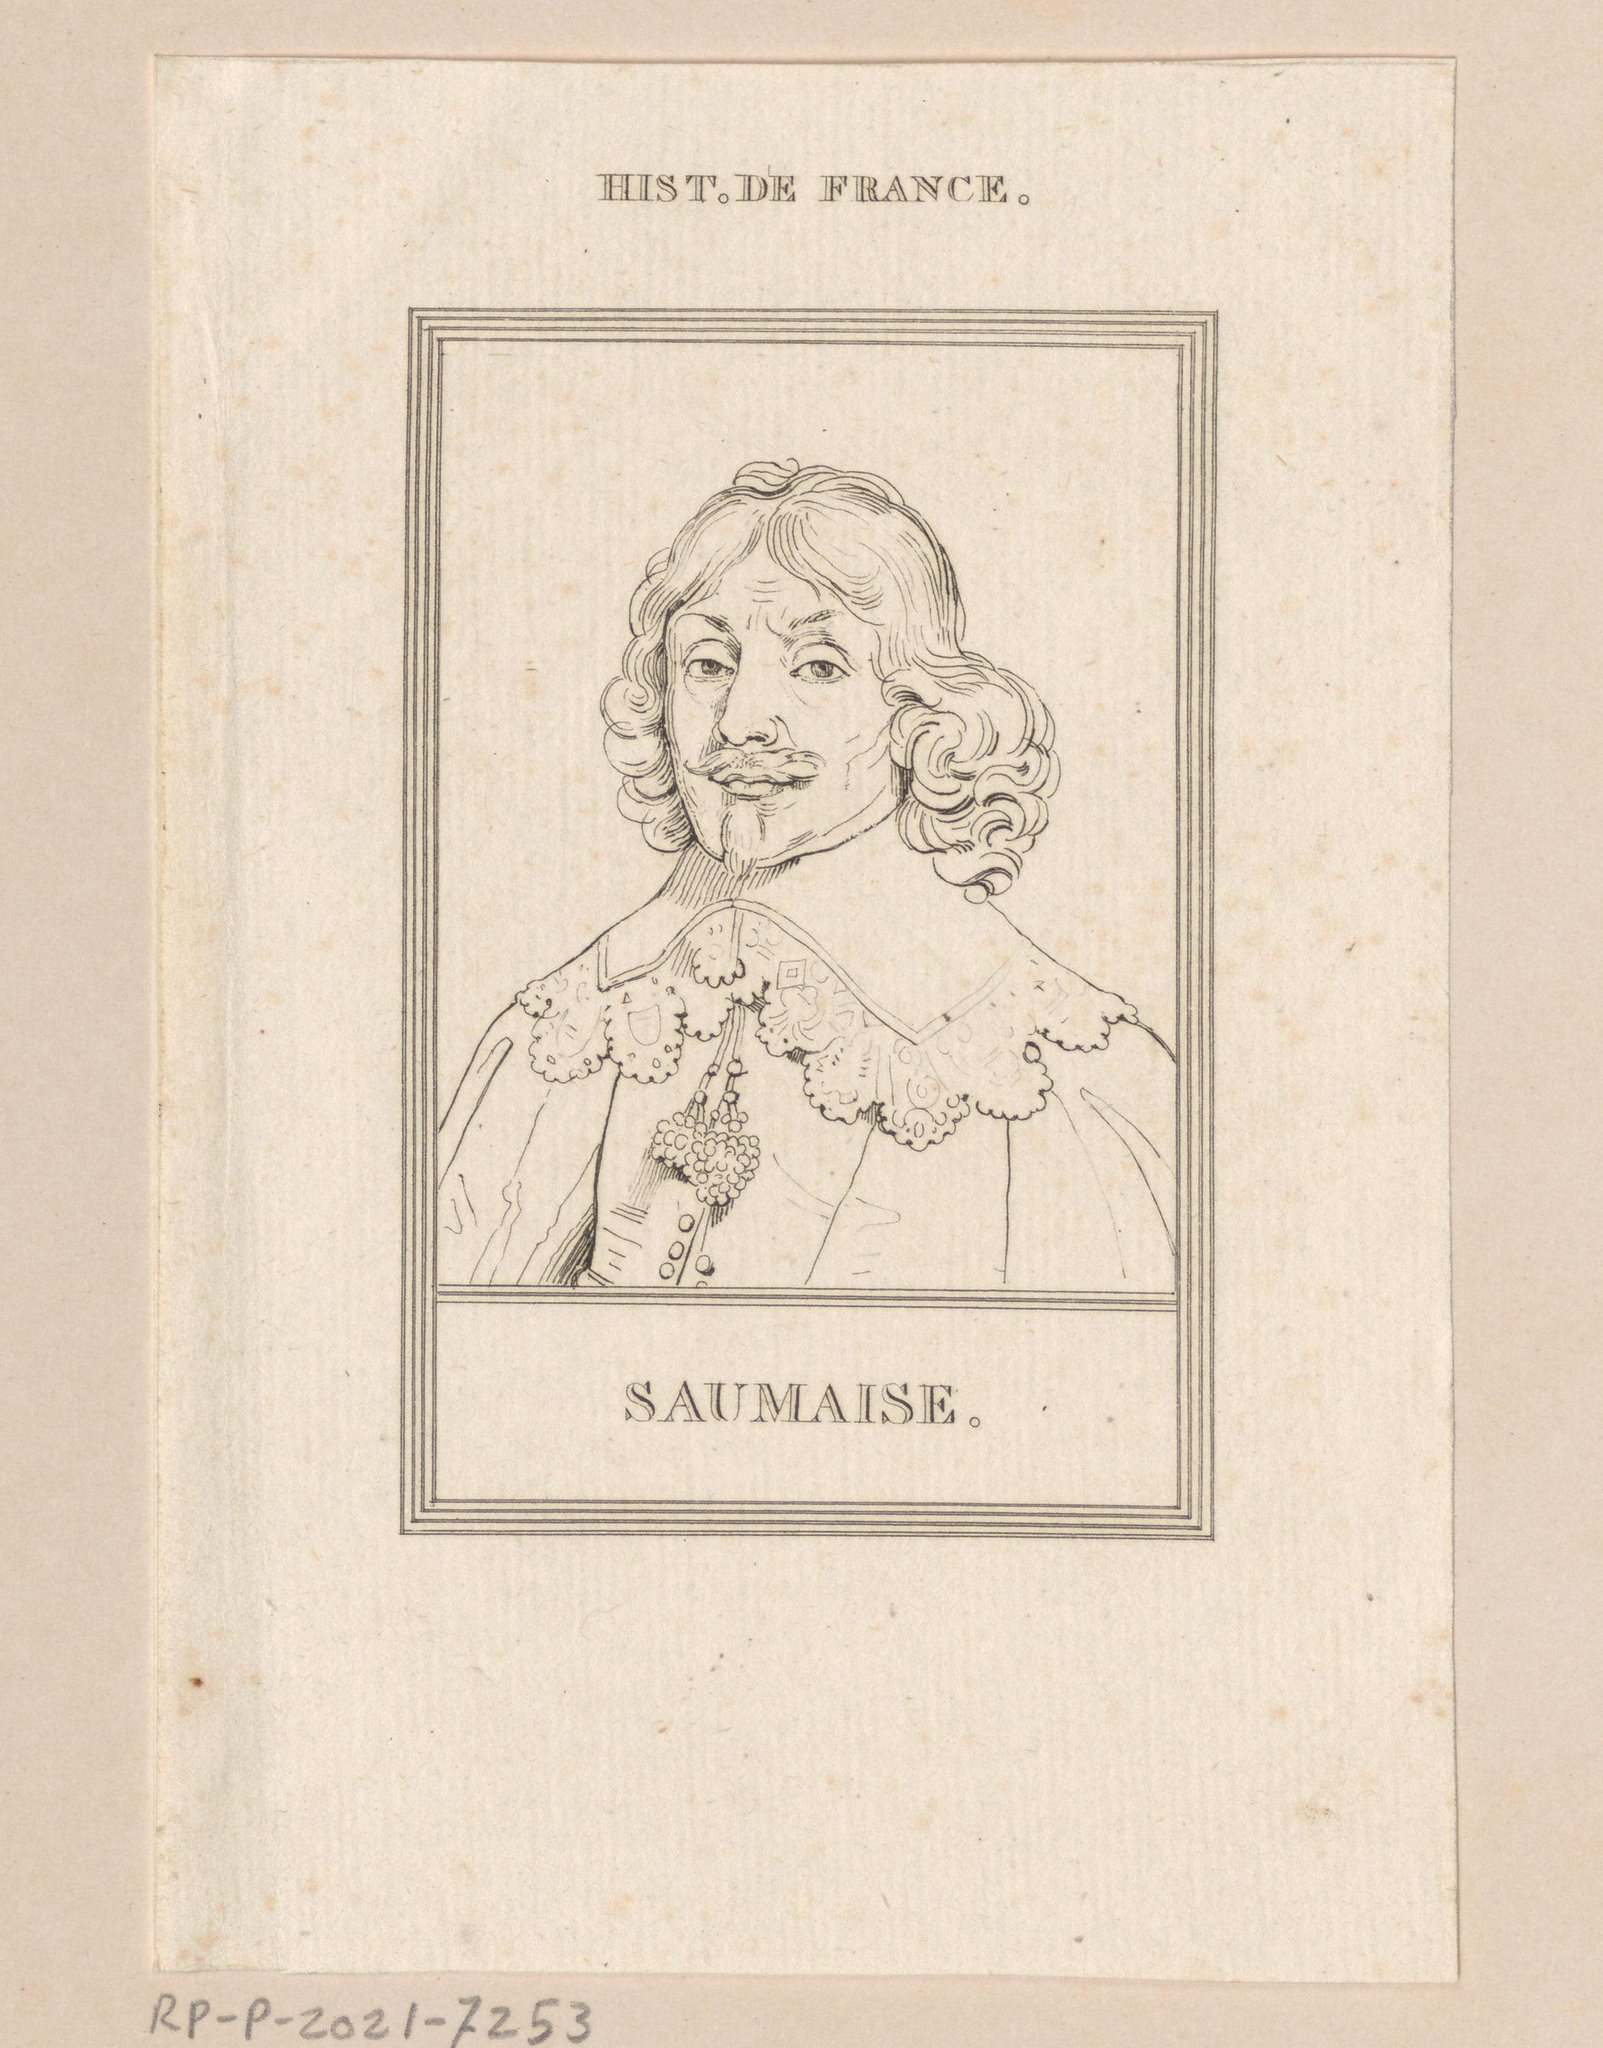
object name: print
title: Portret van Claudius Salmasius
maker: Anonymous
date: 1811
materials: paper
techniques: etching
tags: claudius salmasius, historical persons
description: Prent waarschijnlijk uit: Galerie historique des hommes les plus celebres de tous les nations (...). Parijs: Charles Paul Landon, 1811, dl. 13.